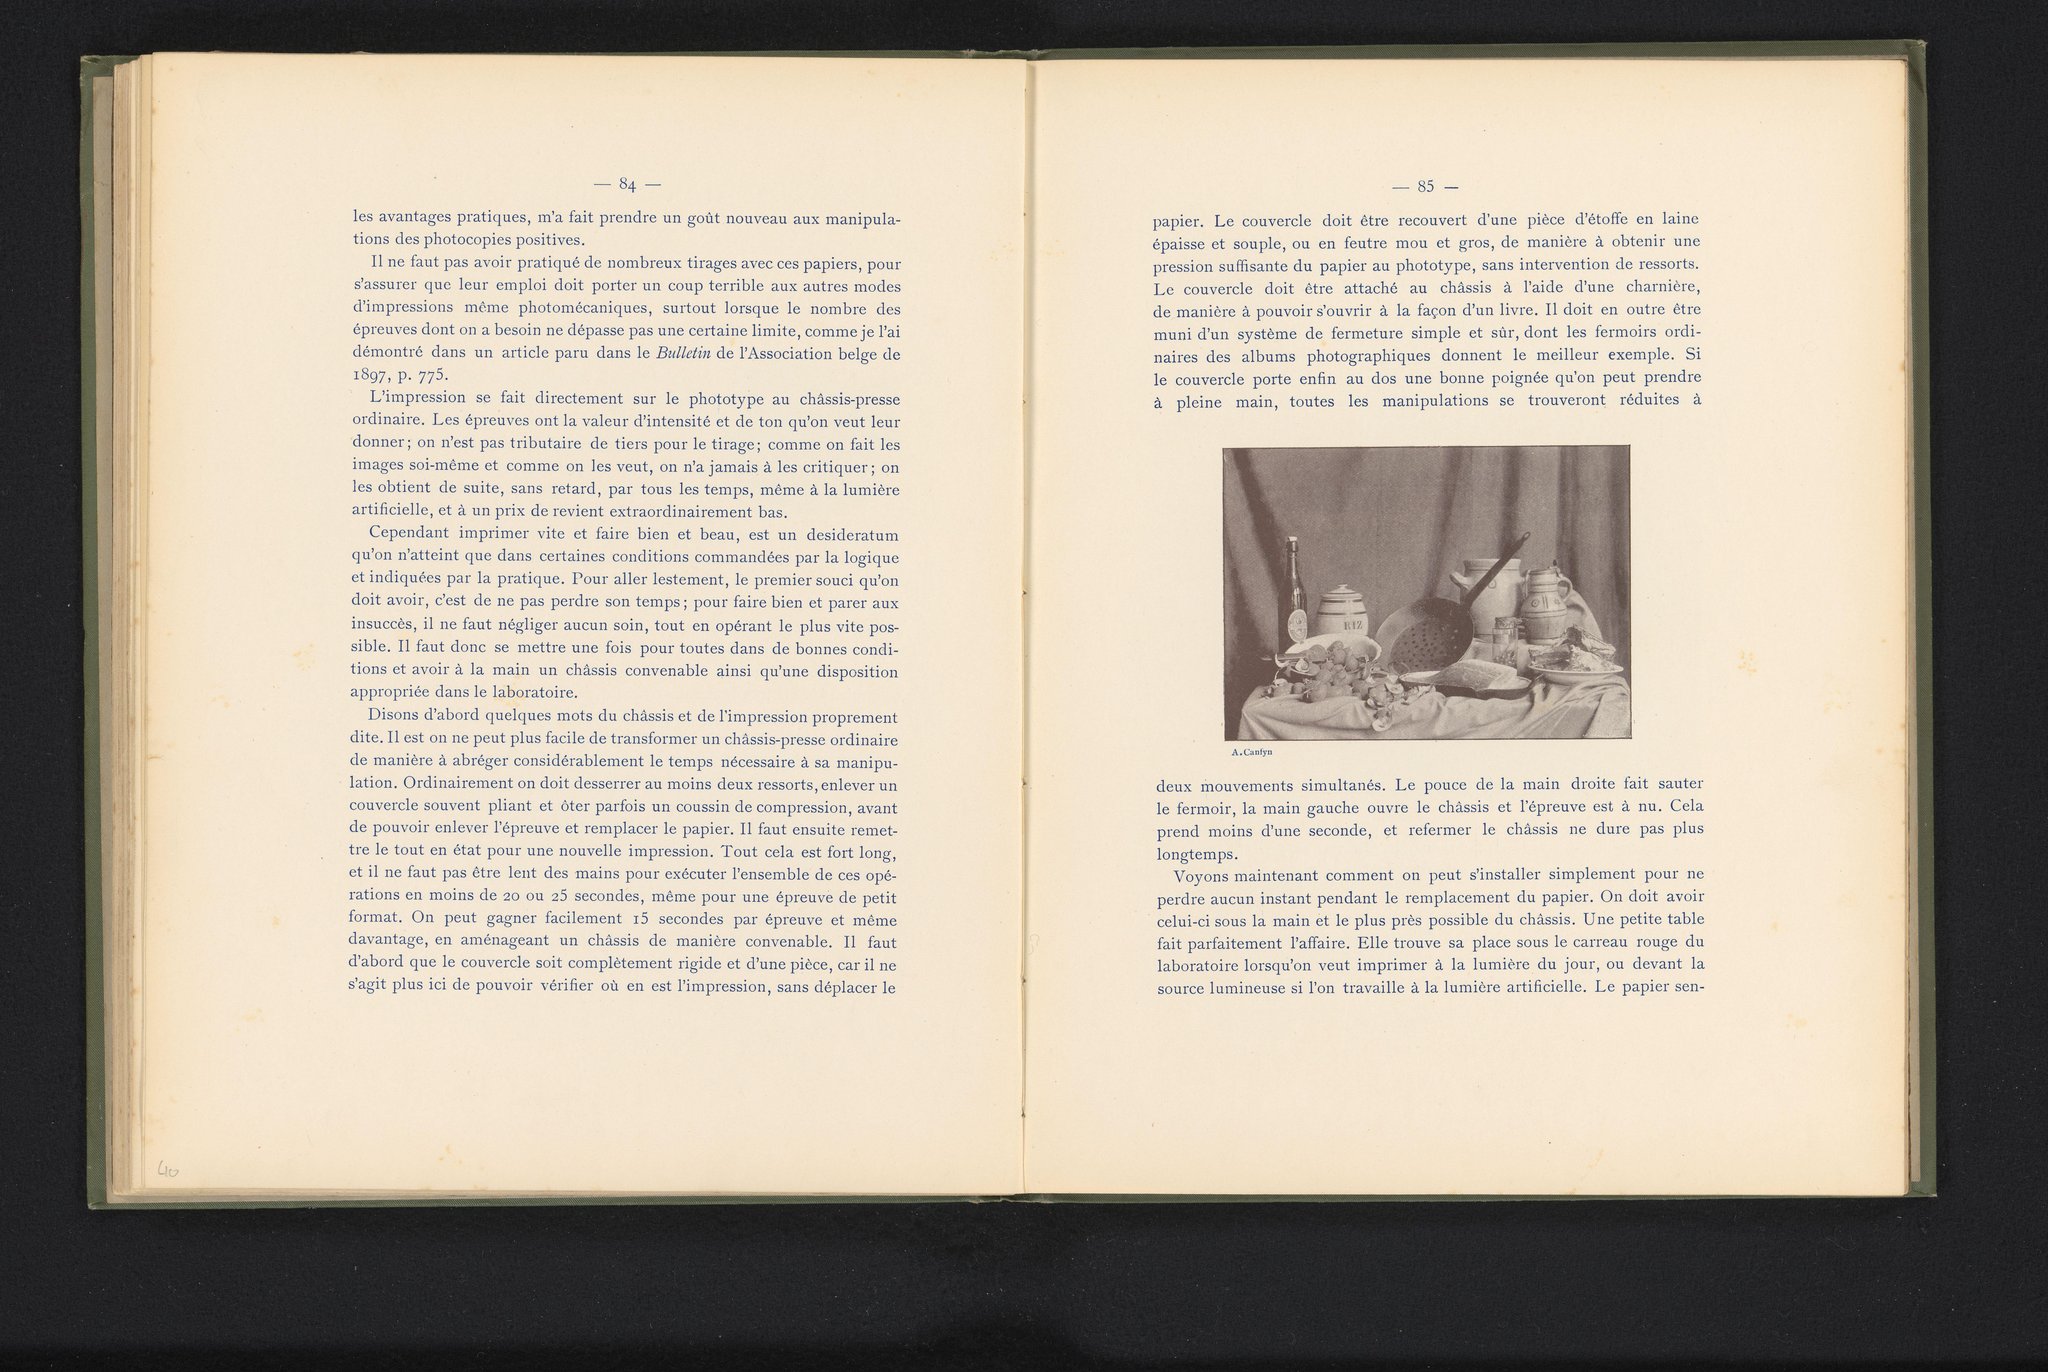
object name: photomechanical print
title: Stilleven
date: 1893-1898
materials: paper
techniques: autotype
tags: laid table as still life